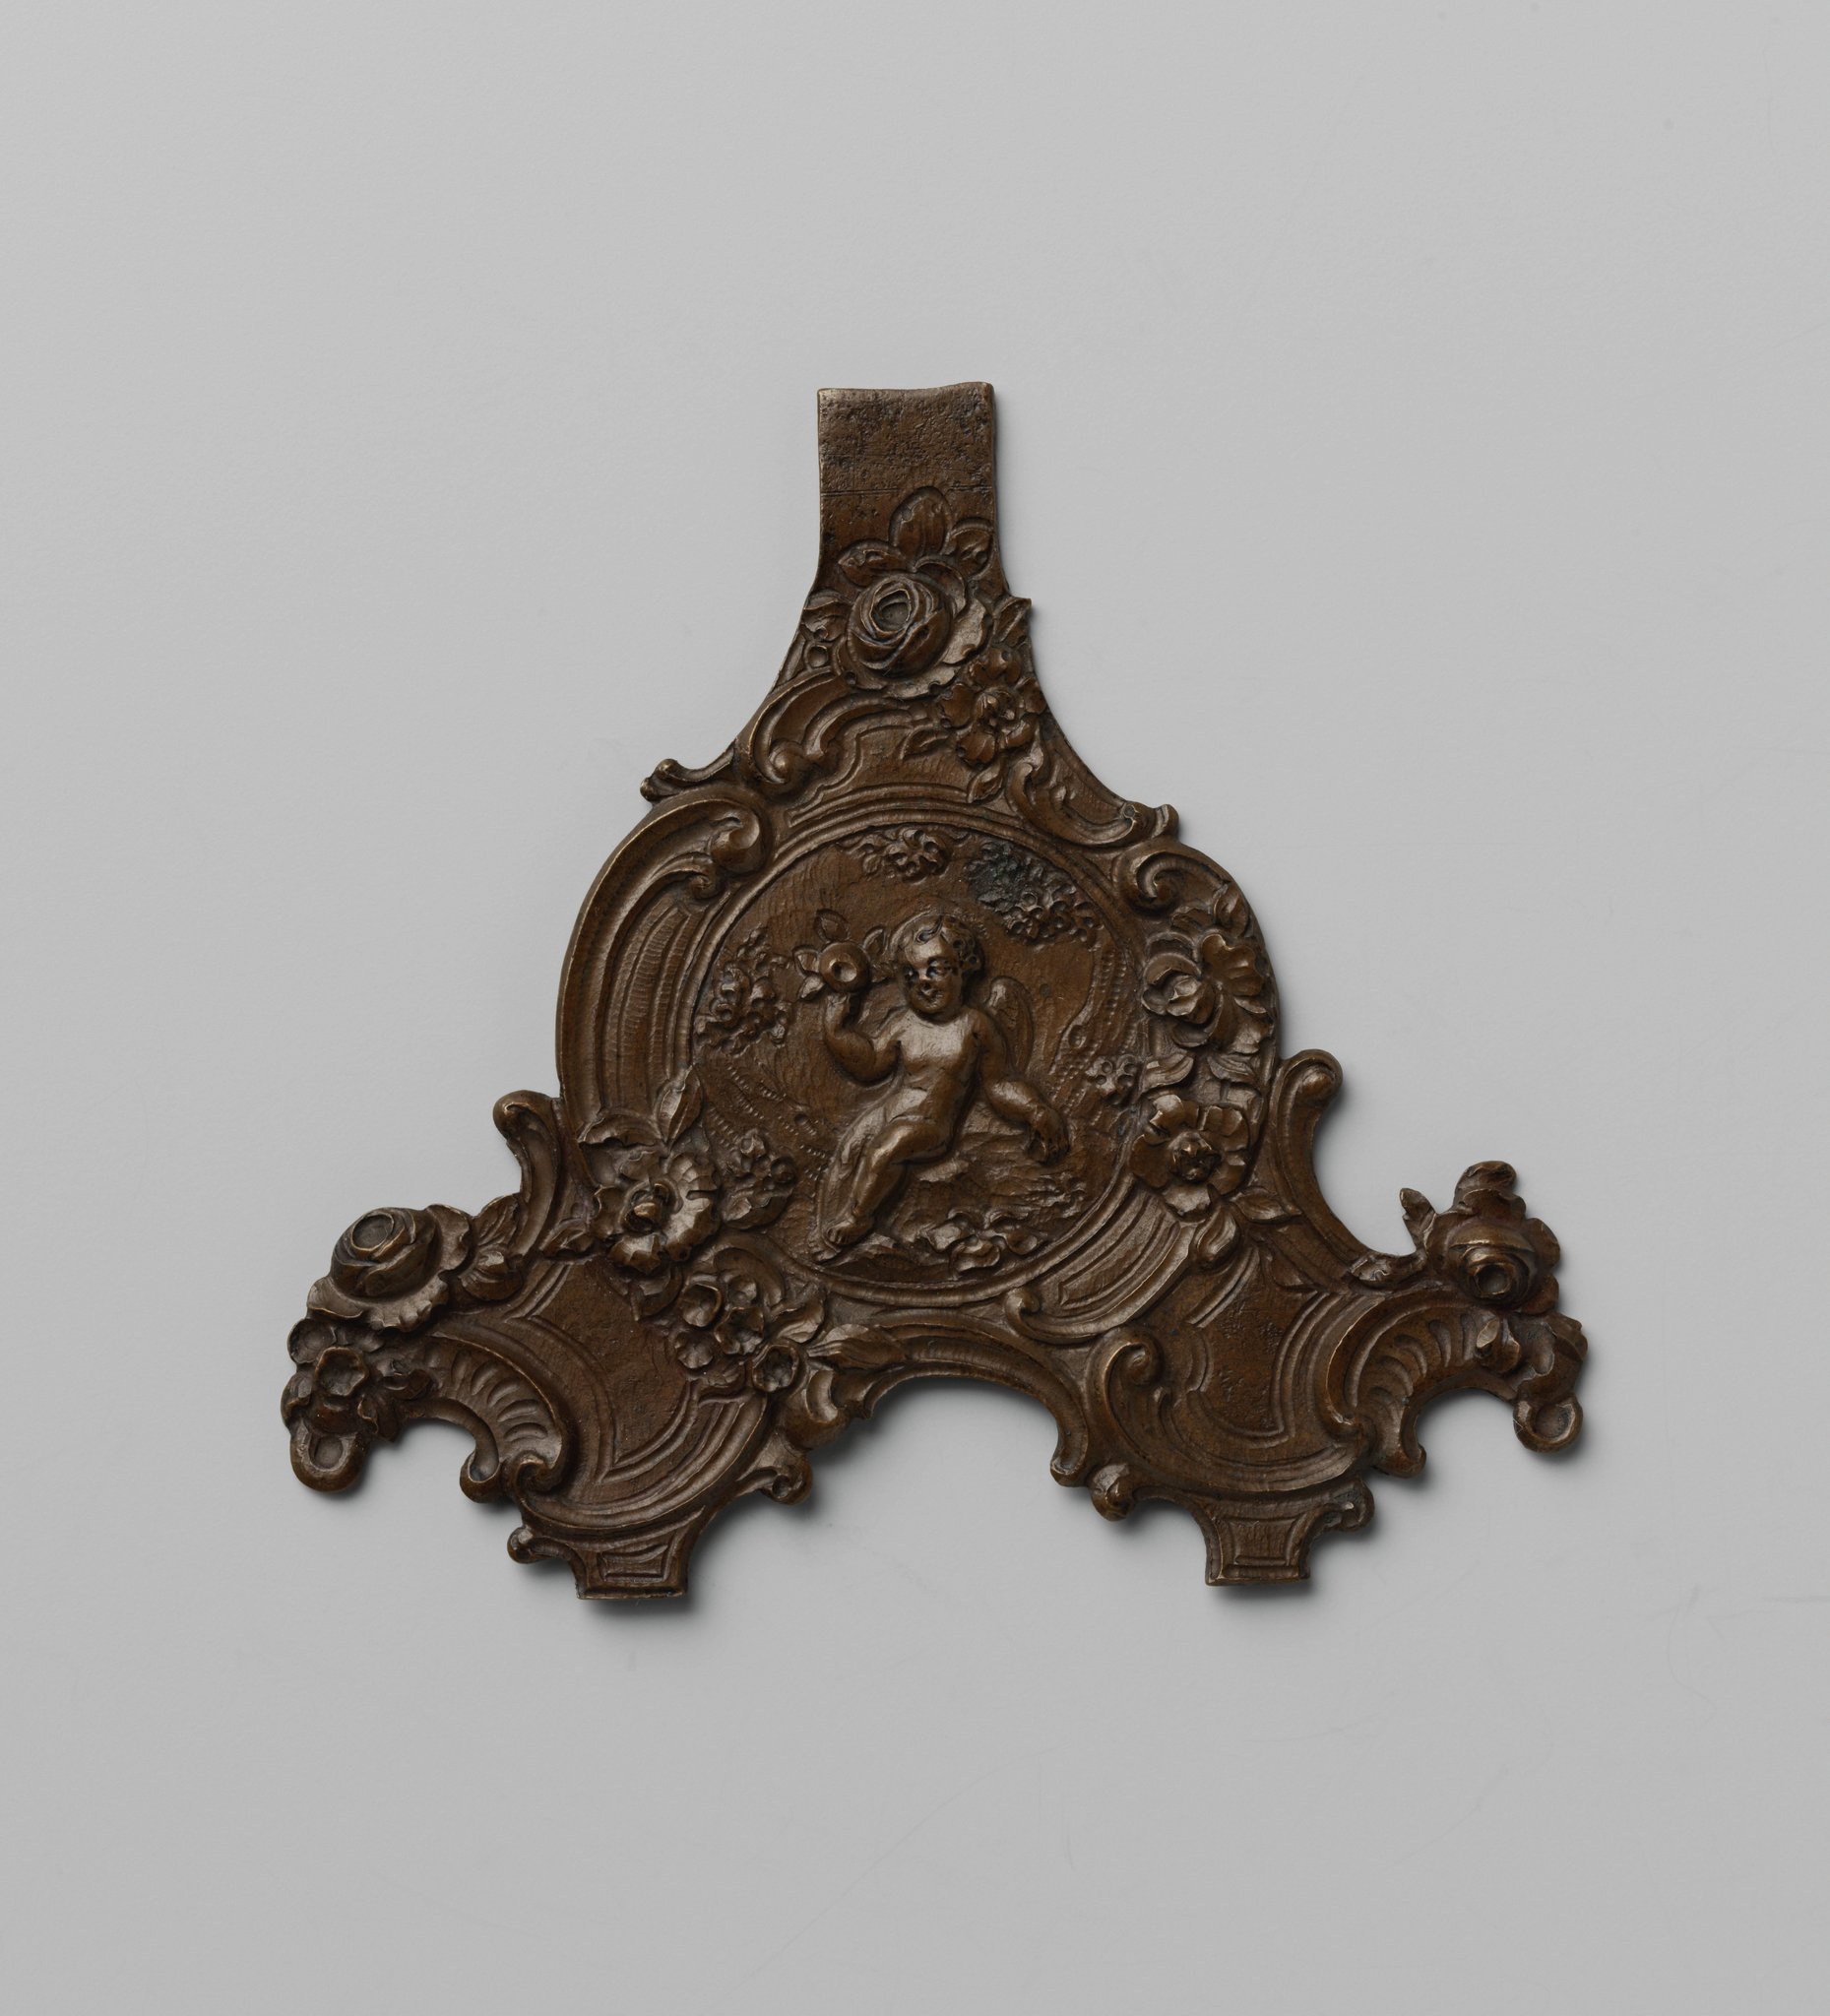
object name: model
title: Model voor een haakplaat van een chatelaine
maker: Anonymous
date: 1750-1775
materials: copper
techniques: repoussé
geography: amsterdam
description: Het uit plaat gedreven driehoekige model voor een gietvorm is voorzien van een door rococo-ornament en bloemen omgeven medaillon met een putto en een zonne(?)bloem. Op de einden links en rechts twee ogen ter bevestiging van schakels.